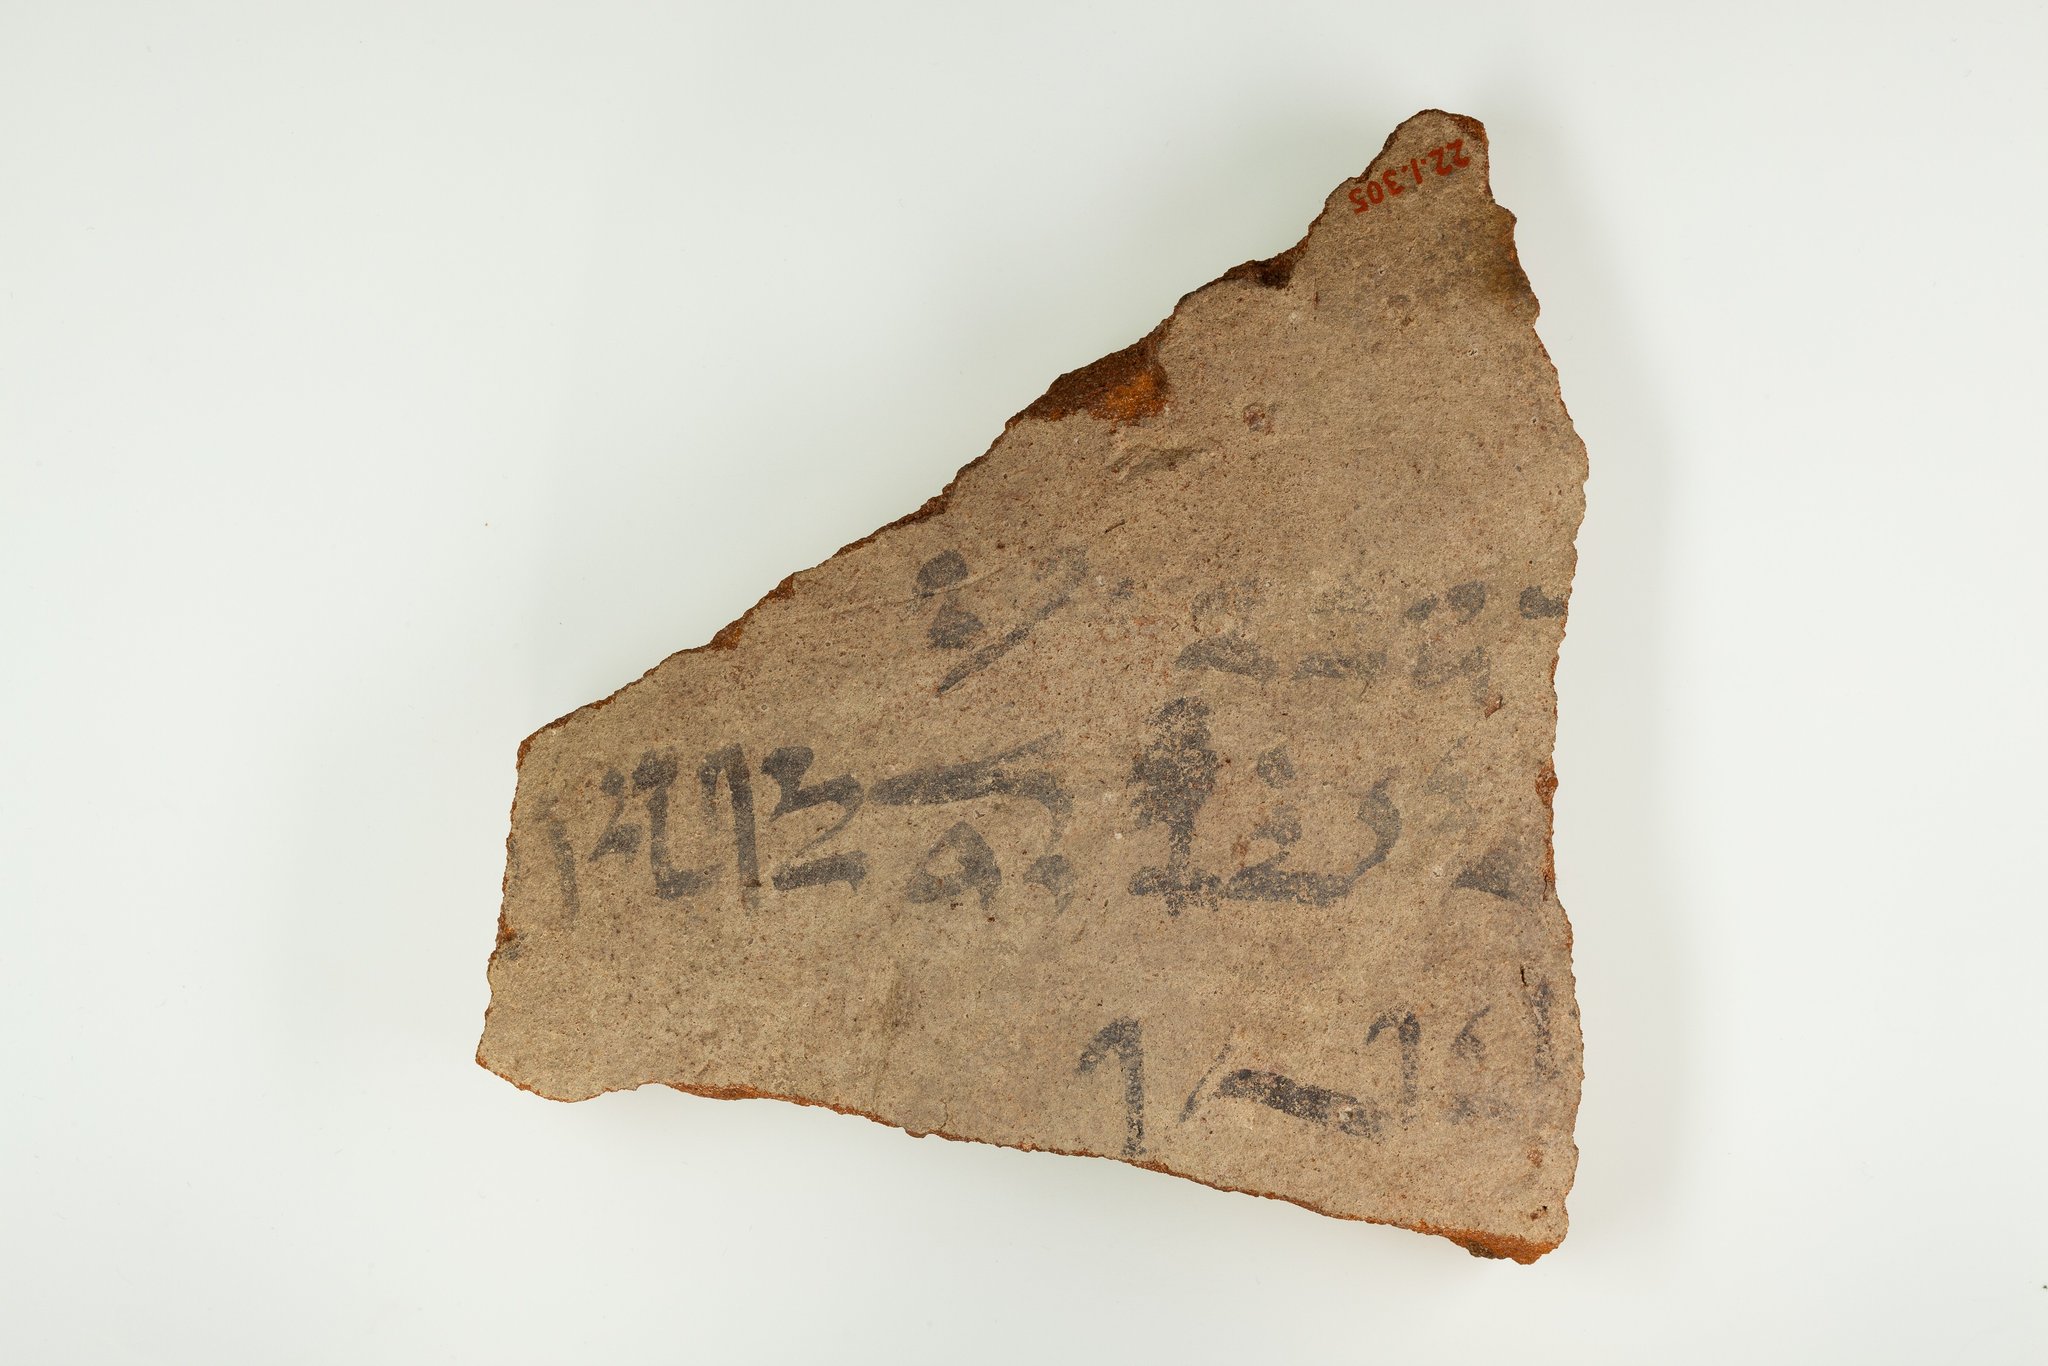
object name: ostracon, hieratic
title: Ostracon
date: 1981-1640 BCE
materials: ink, pottery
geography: egypt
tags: hieratic